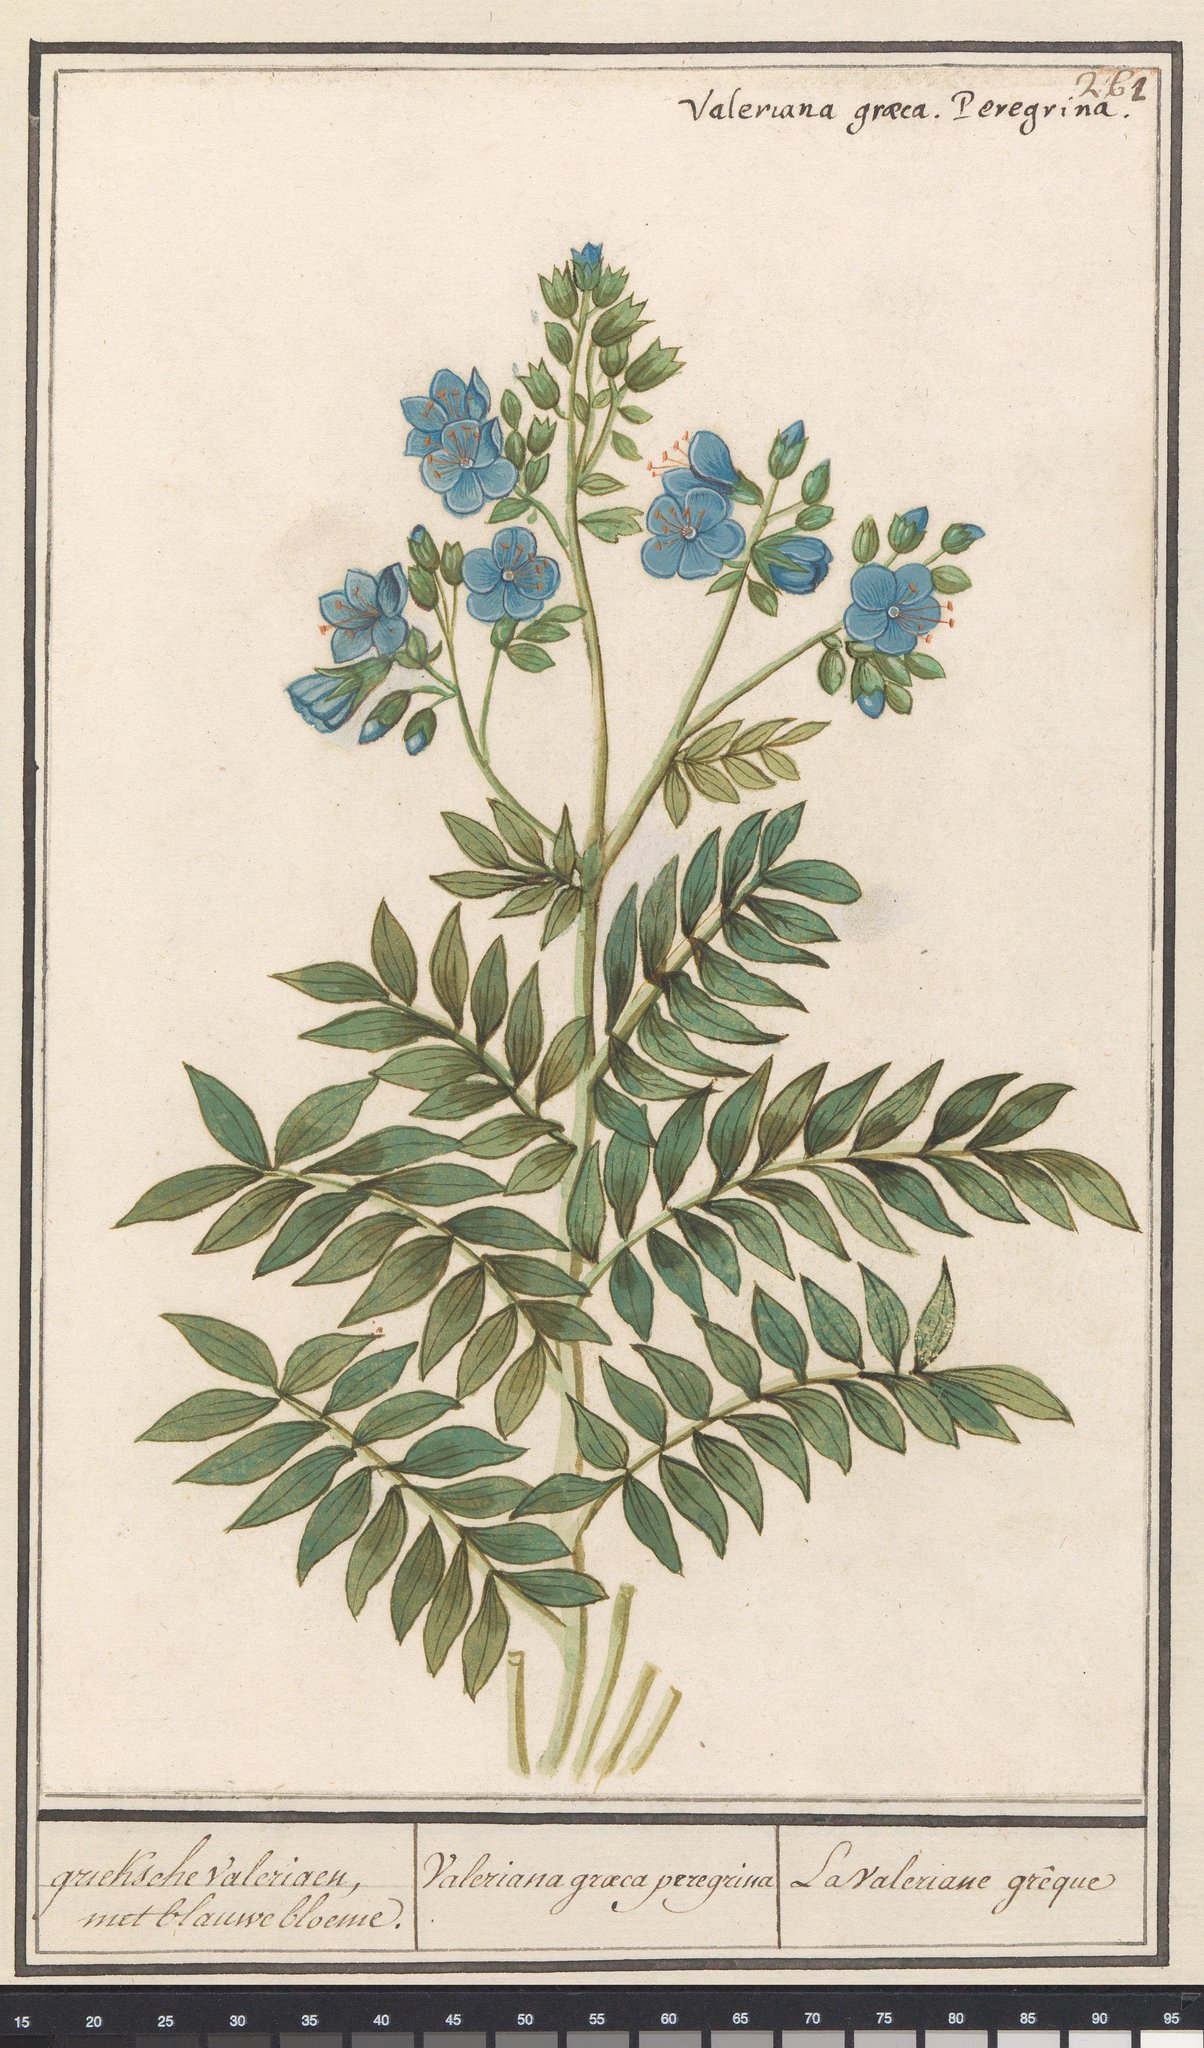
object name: drawing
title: grieksche Valeriaen, met blauwe bloeme. / Valeriana graeca peregrima / La Valeriane grêque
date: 1596-1610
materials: chalk, paint, ink, paper, watercolor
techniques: brush, pen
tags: flowers: jacob's-ladder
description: Jacobsladder of Griekse valeriaan. Genummerd rechtsboven: 261. Rechtsboven de Latijnse naam. Onderdeel van het derde album met tekeningen van bloemen en planten. Tiende van twaalf albums met tekeningen van dieren, vogels en planten bekend rond 1600, gemaakt in opdracht van keizer Rudolf II. Met toelichting in Nederlands, Latijn en Frans.